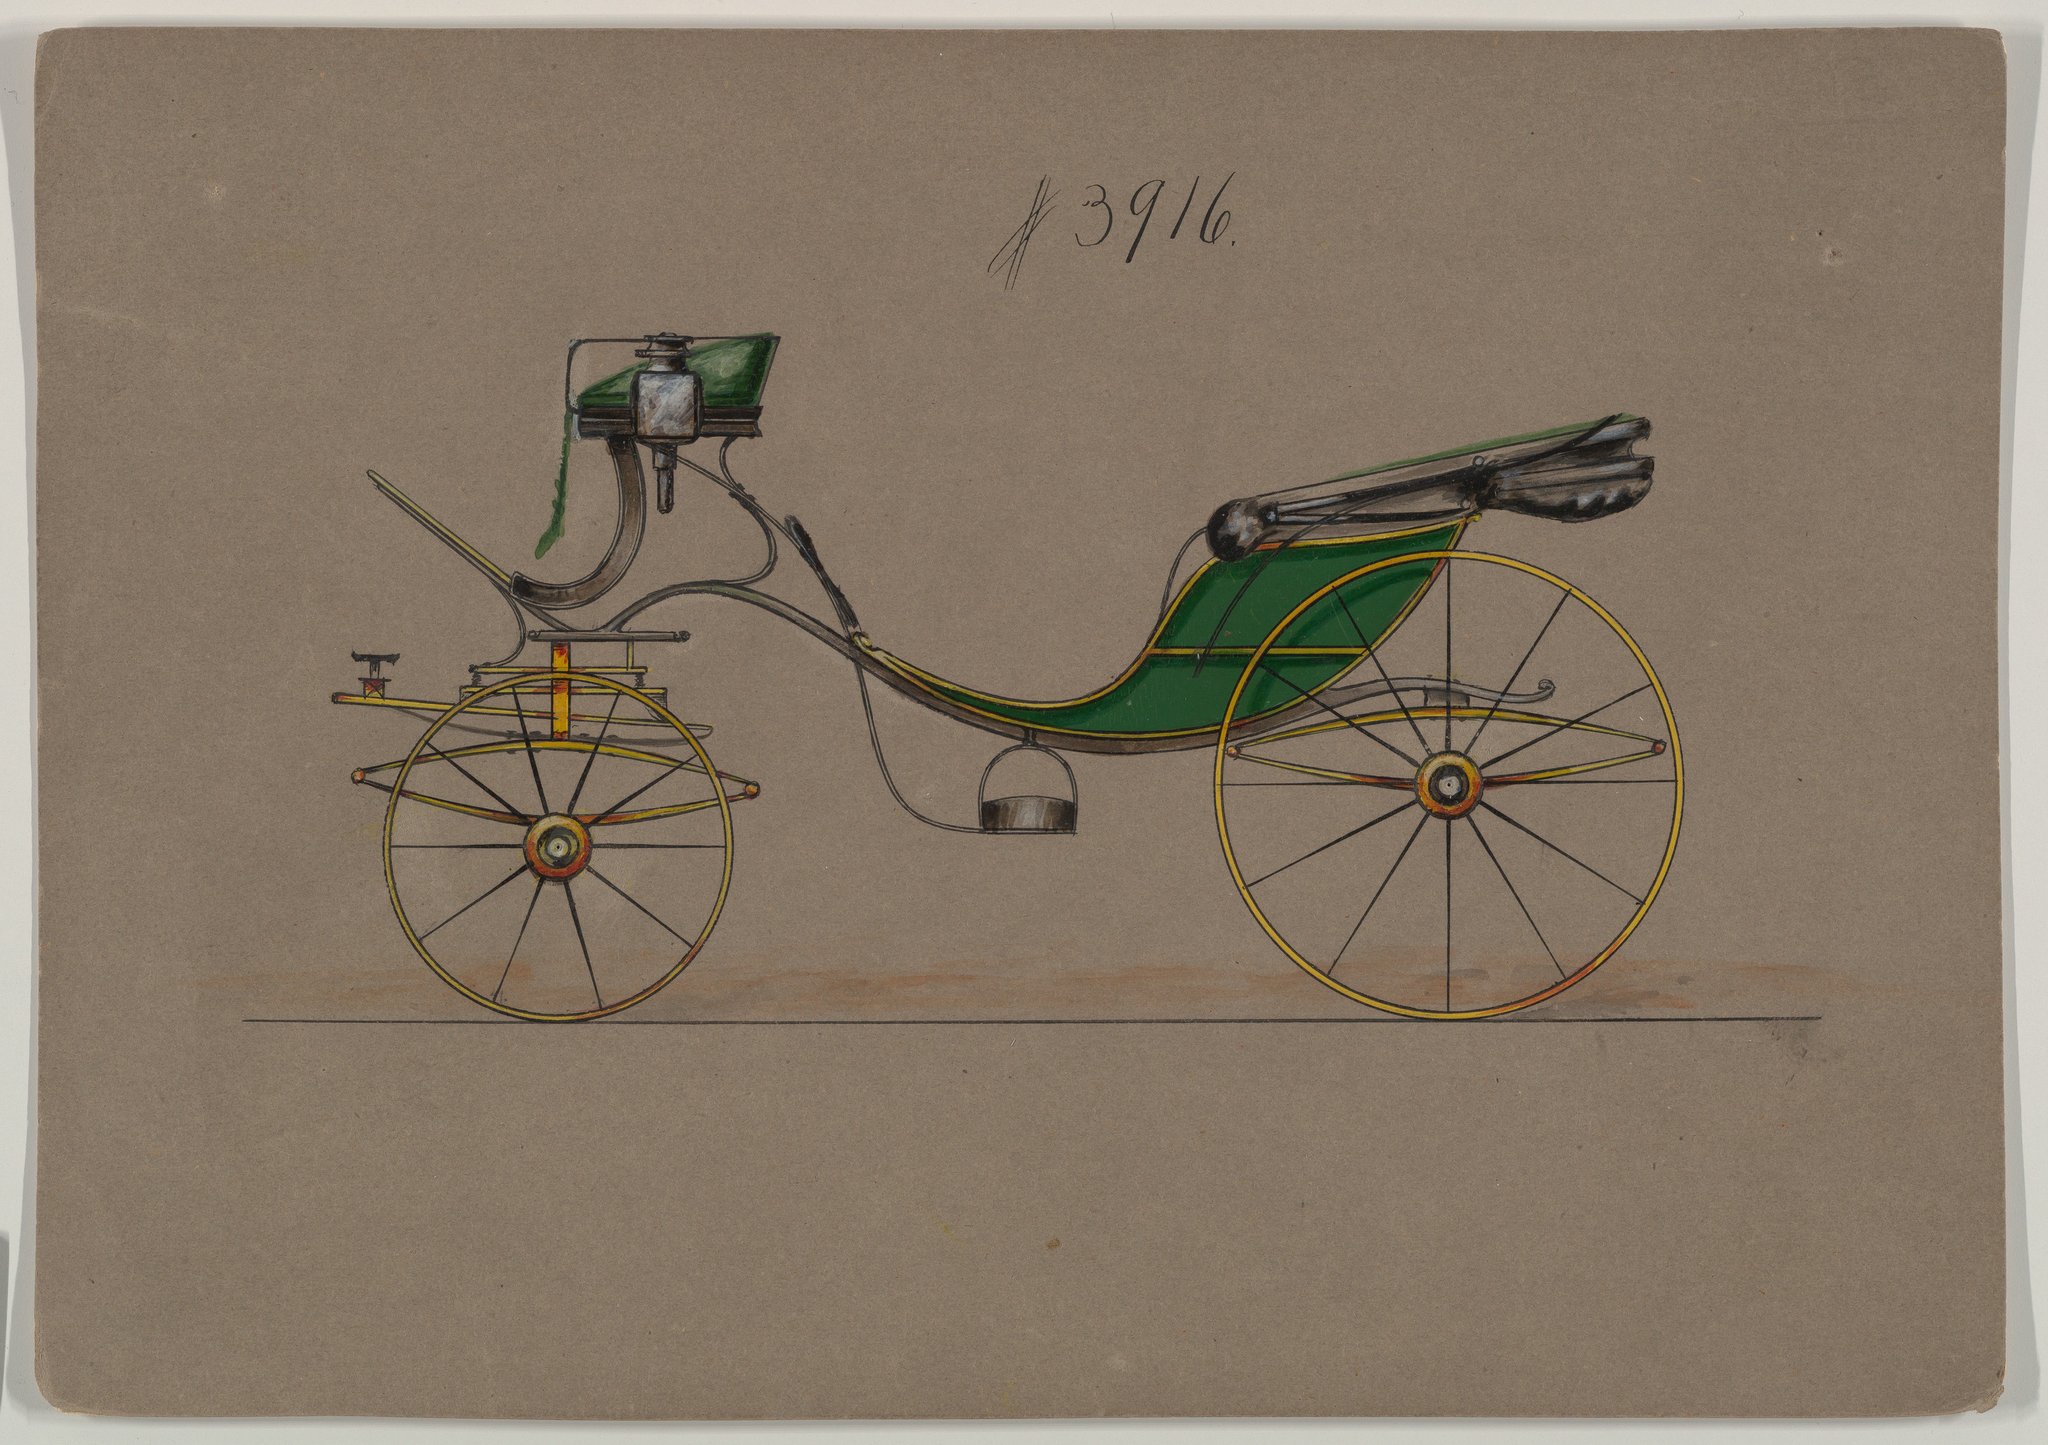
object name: drawing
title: Victoria #3916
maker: brewster & co.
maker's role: manufacturer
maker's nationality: american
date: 1884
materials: gum arabic, ink, watercolor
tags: carriages